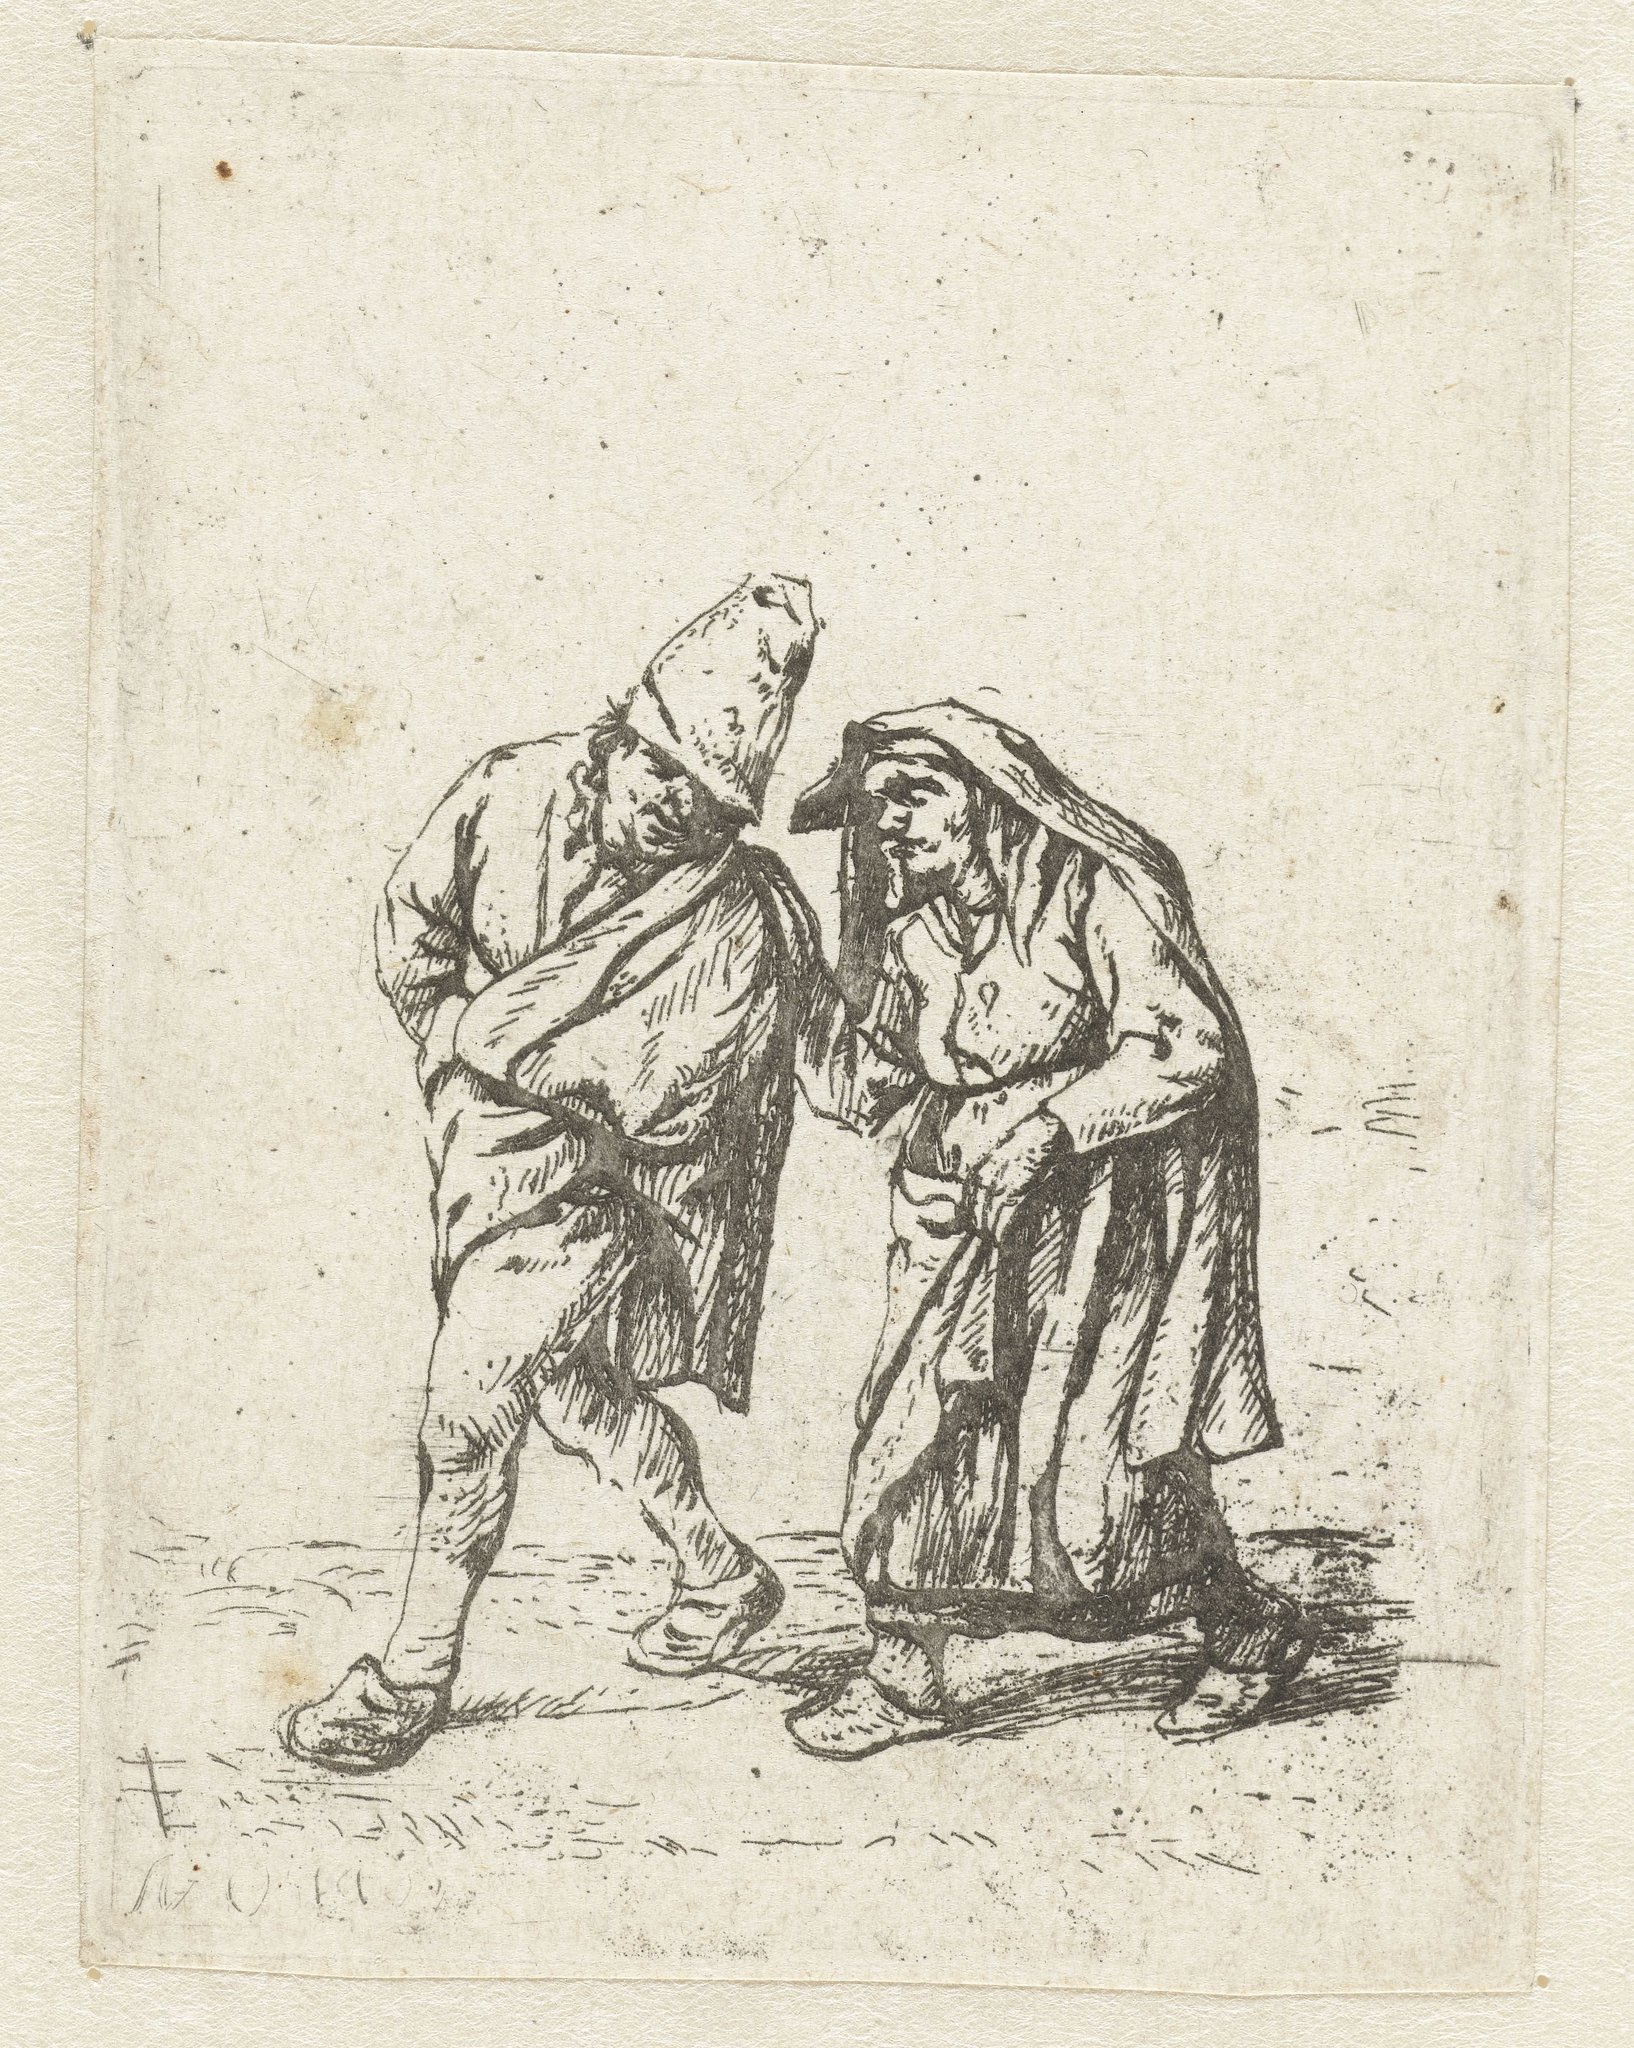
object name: print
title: Wandelend boerenpaar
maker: Anonymous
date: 1646-1745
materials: paper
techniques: etching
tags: farmers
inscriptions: collector's mark: Lugt 240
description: Wandelend boerenpaar is een kopie naar een prent van Adriaen van Ostade, de figuren zijn spiegelverkeerd weergegeven.